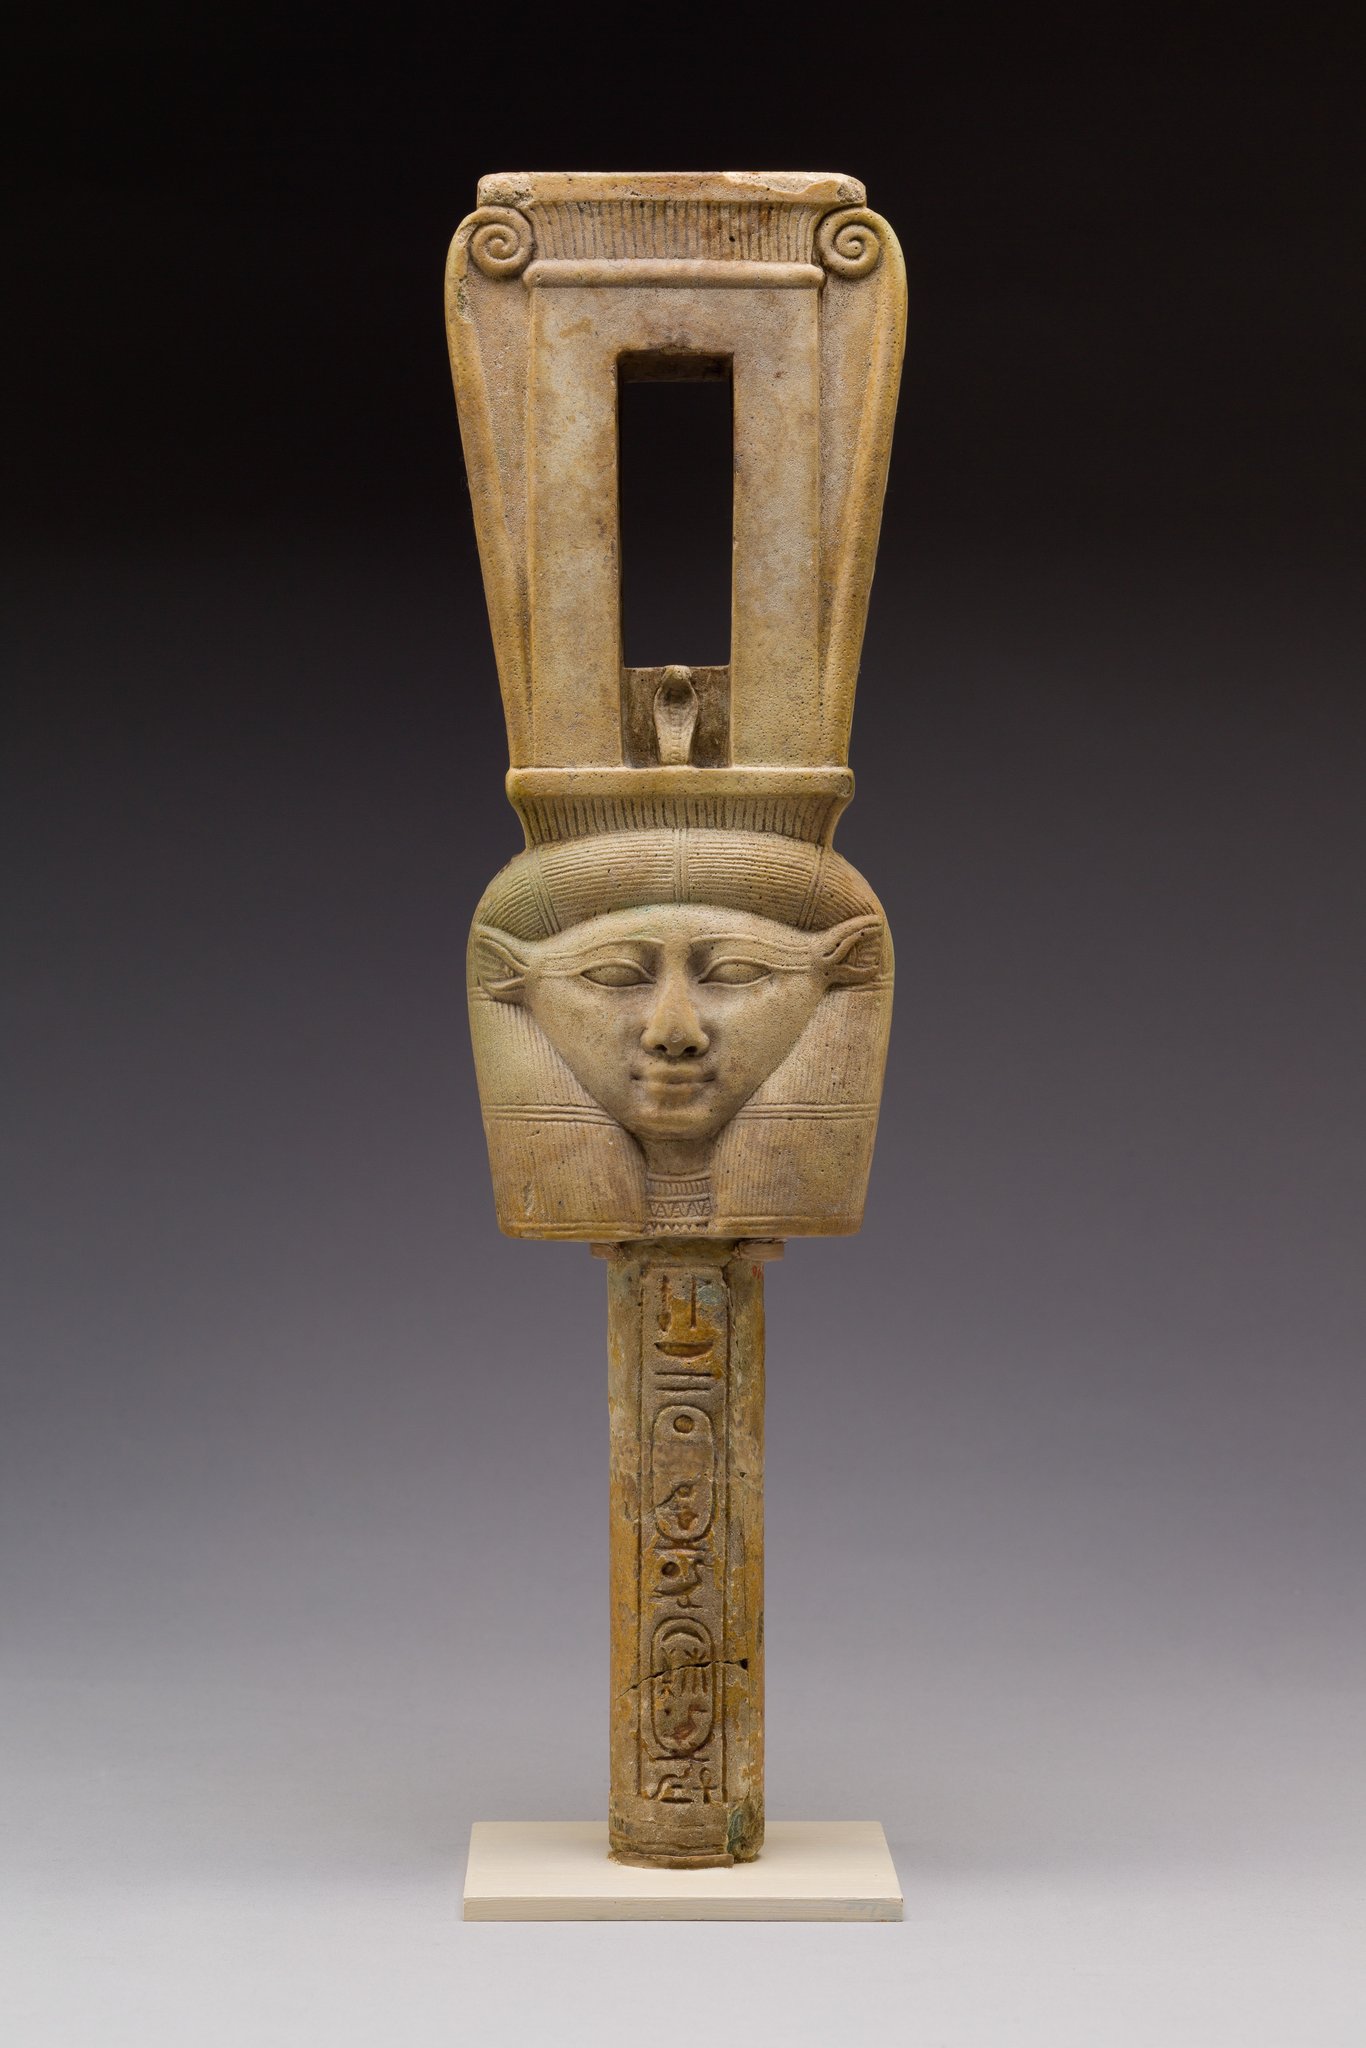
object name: music, sistrum, hathor emblem, bat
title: Sistrum with the Name of King Amasis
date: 570-526 BCE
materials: faience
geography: egypt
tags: hieroglyphs,hathor